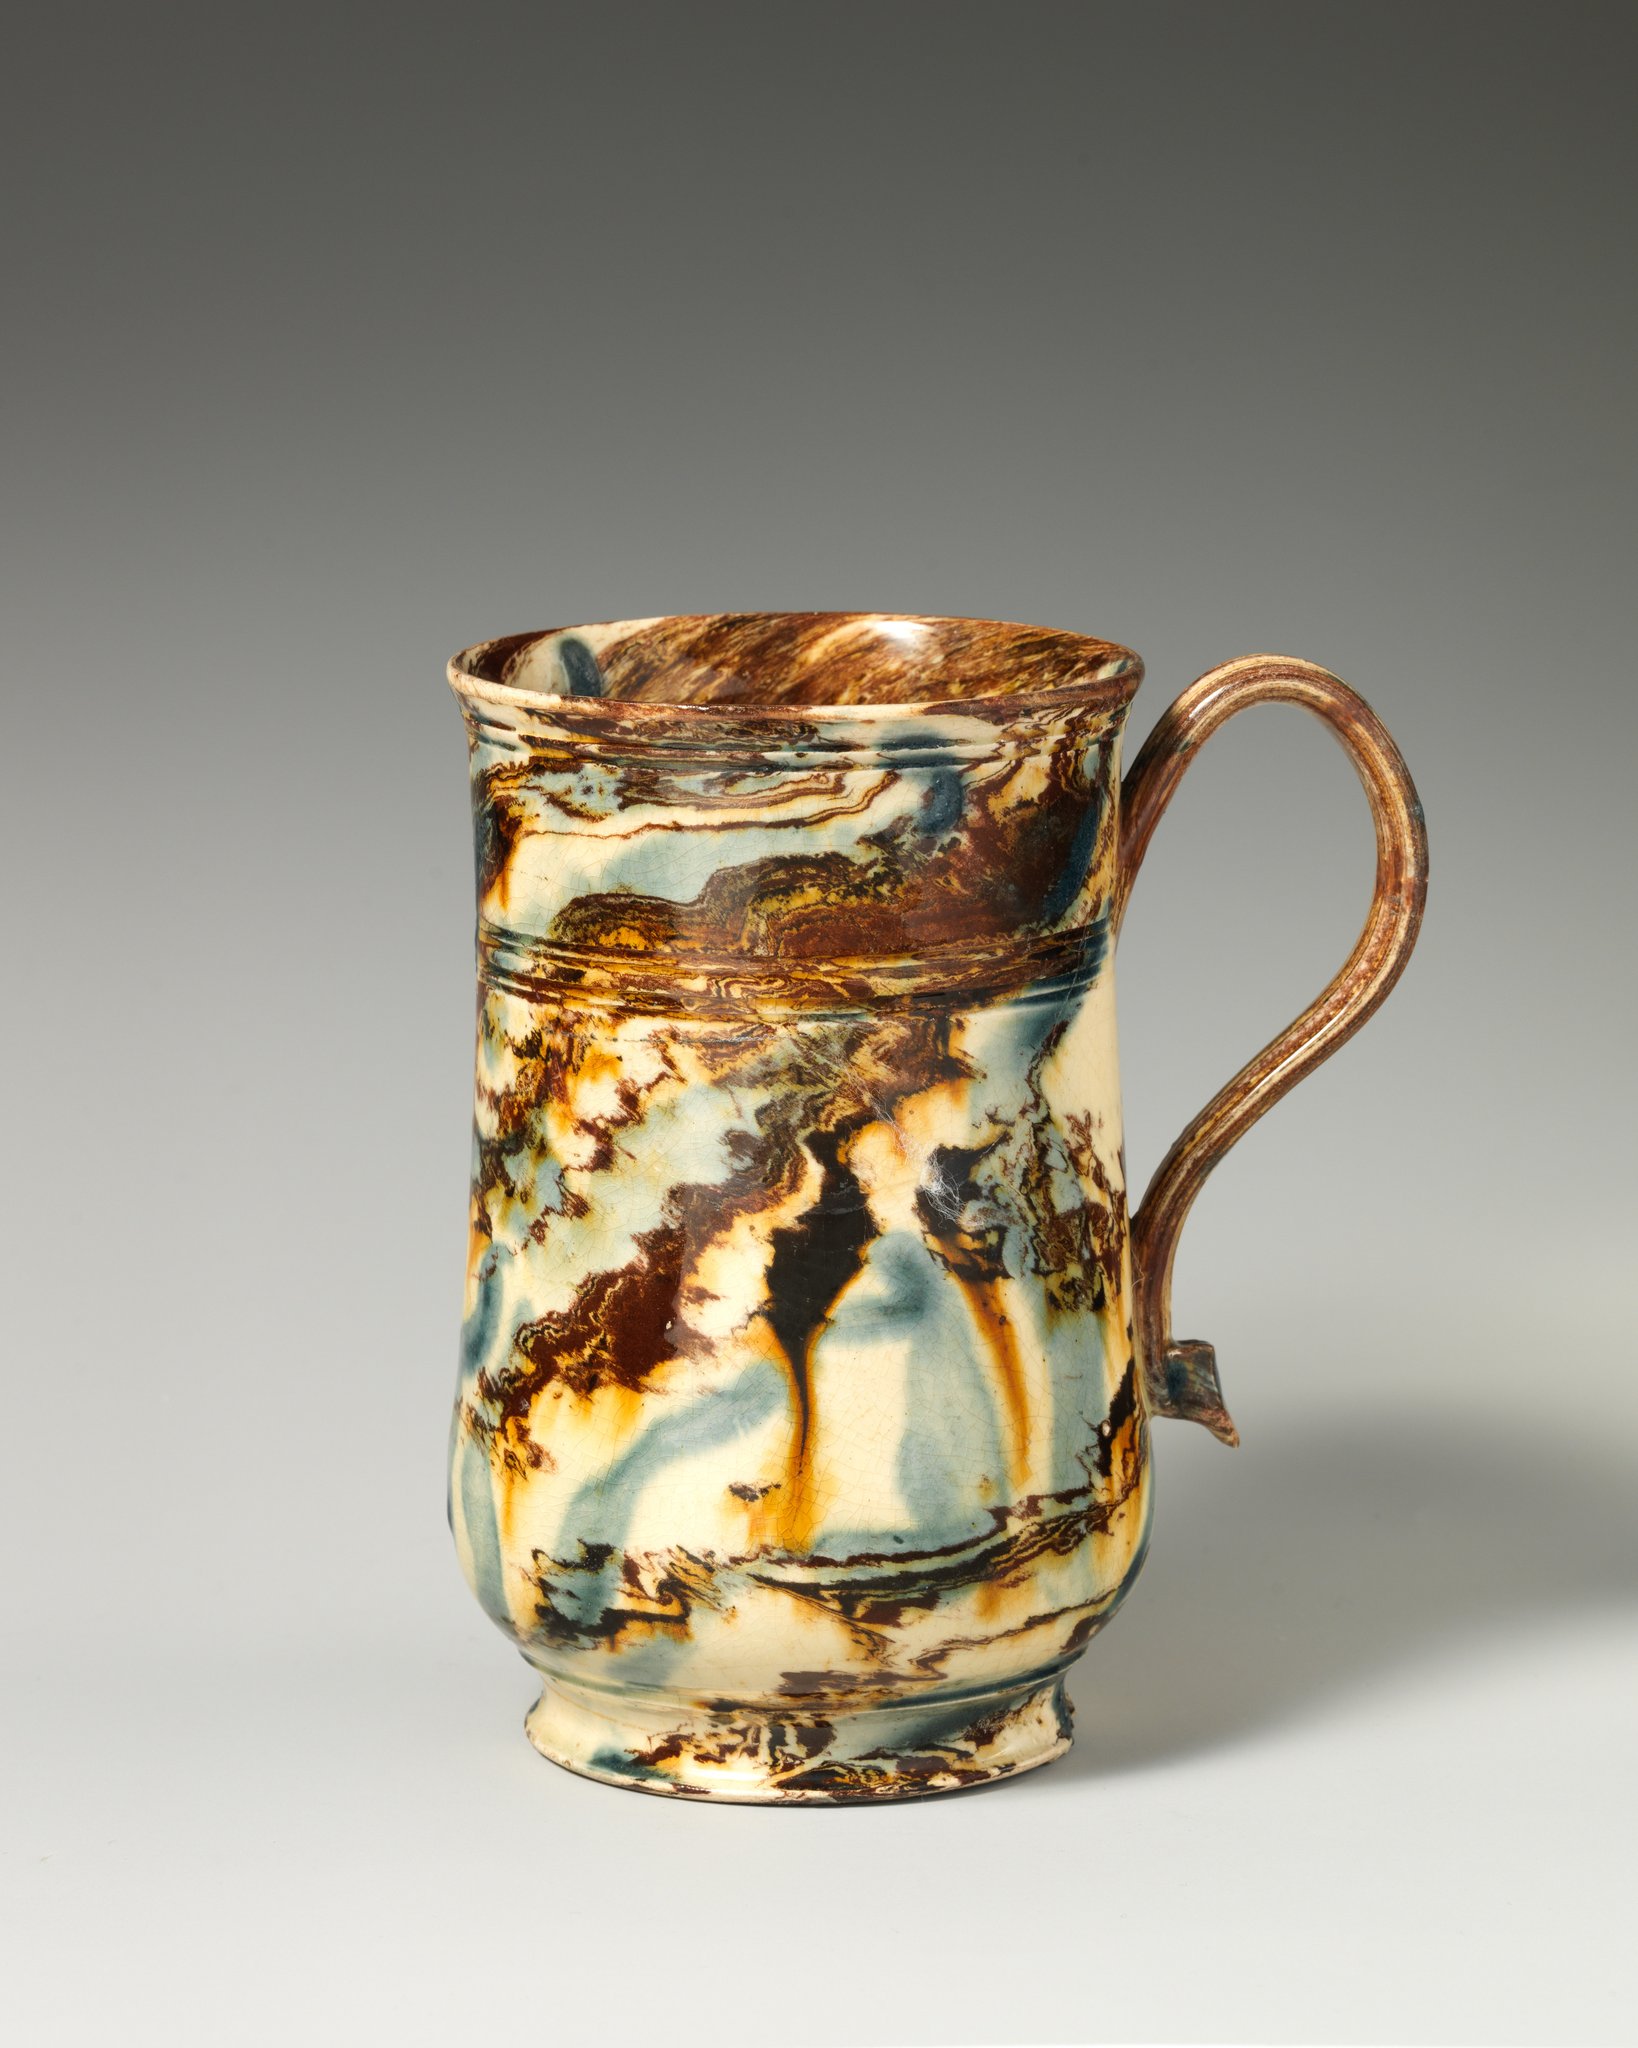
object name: mug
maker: john astbury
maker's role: maker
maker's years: 1688-1743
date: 1750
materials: earthenware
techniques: glazing